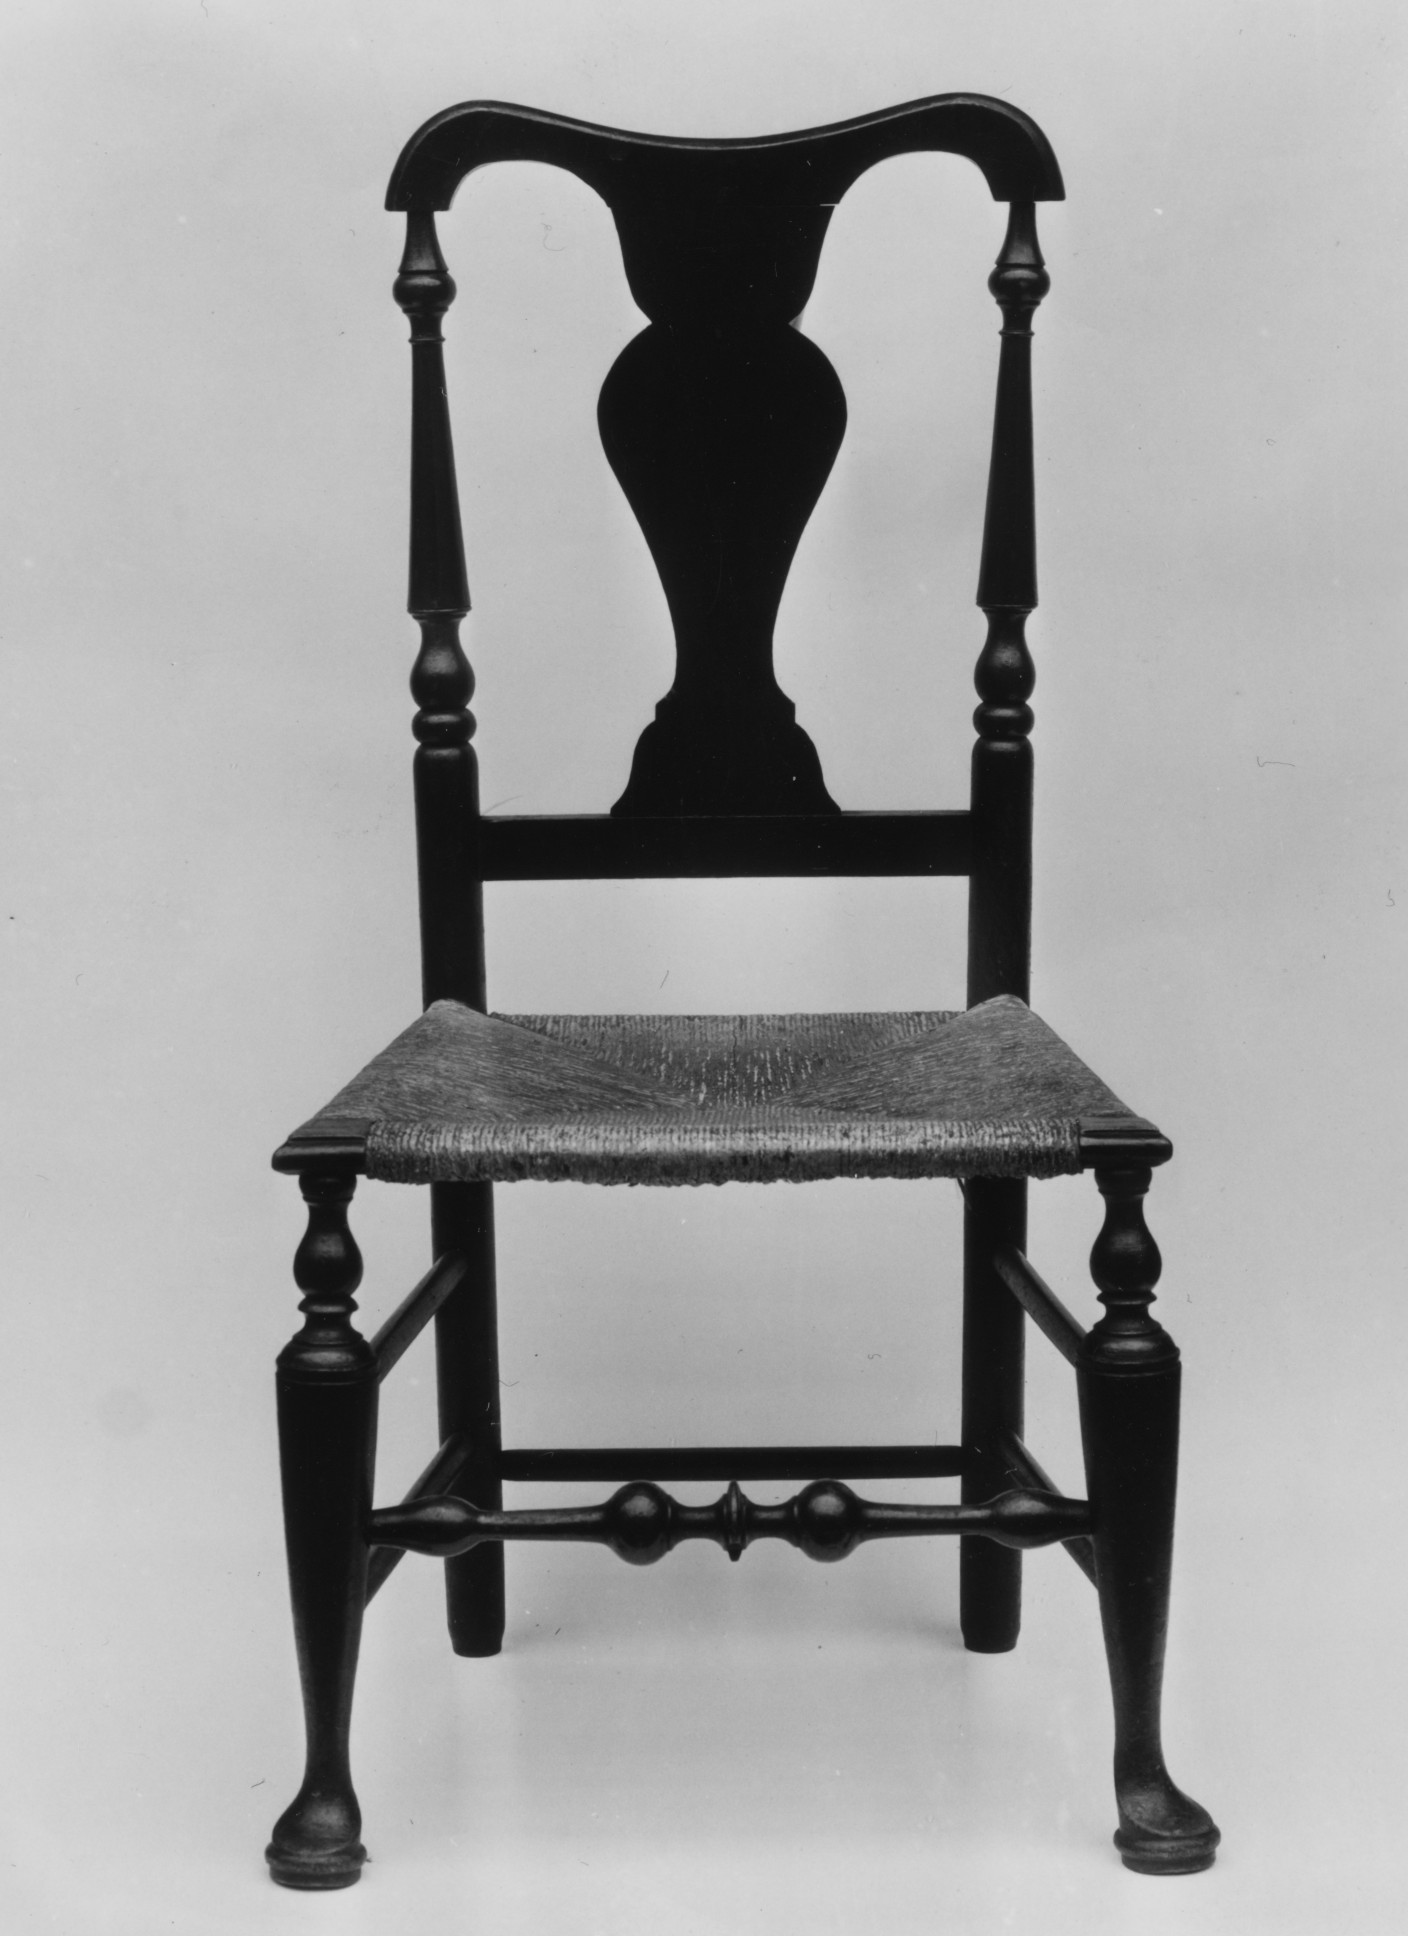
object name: side chair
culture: american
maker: michael smith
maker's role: maker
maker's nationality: american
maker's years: 1736-1836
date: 1775-1800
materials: wood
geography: united states